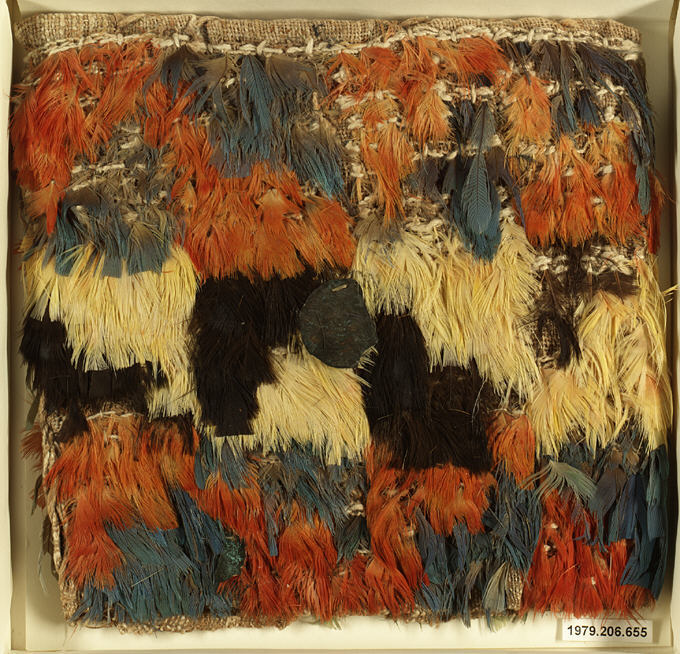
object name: miniature dress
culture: ica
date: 1101-1300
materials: cotton, feather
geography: peru